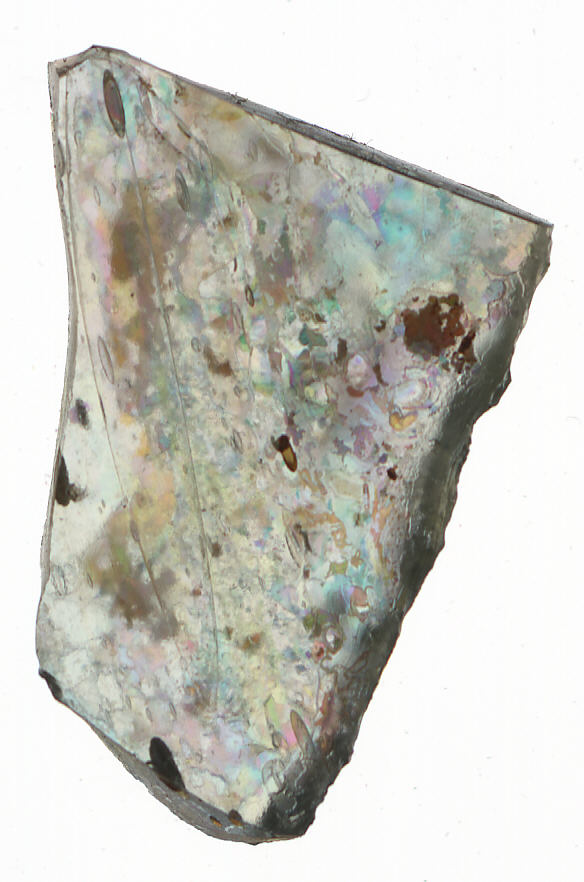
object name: fragment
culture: crusader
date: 1201-1300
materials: glass